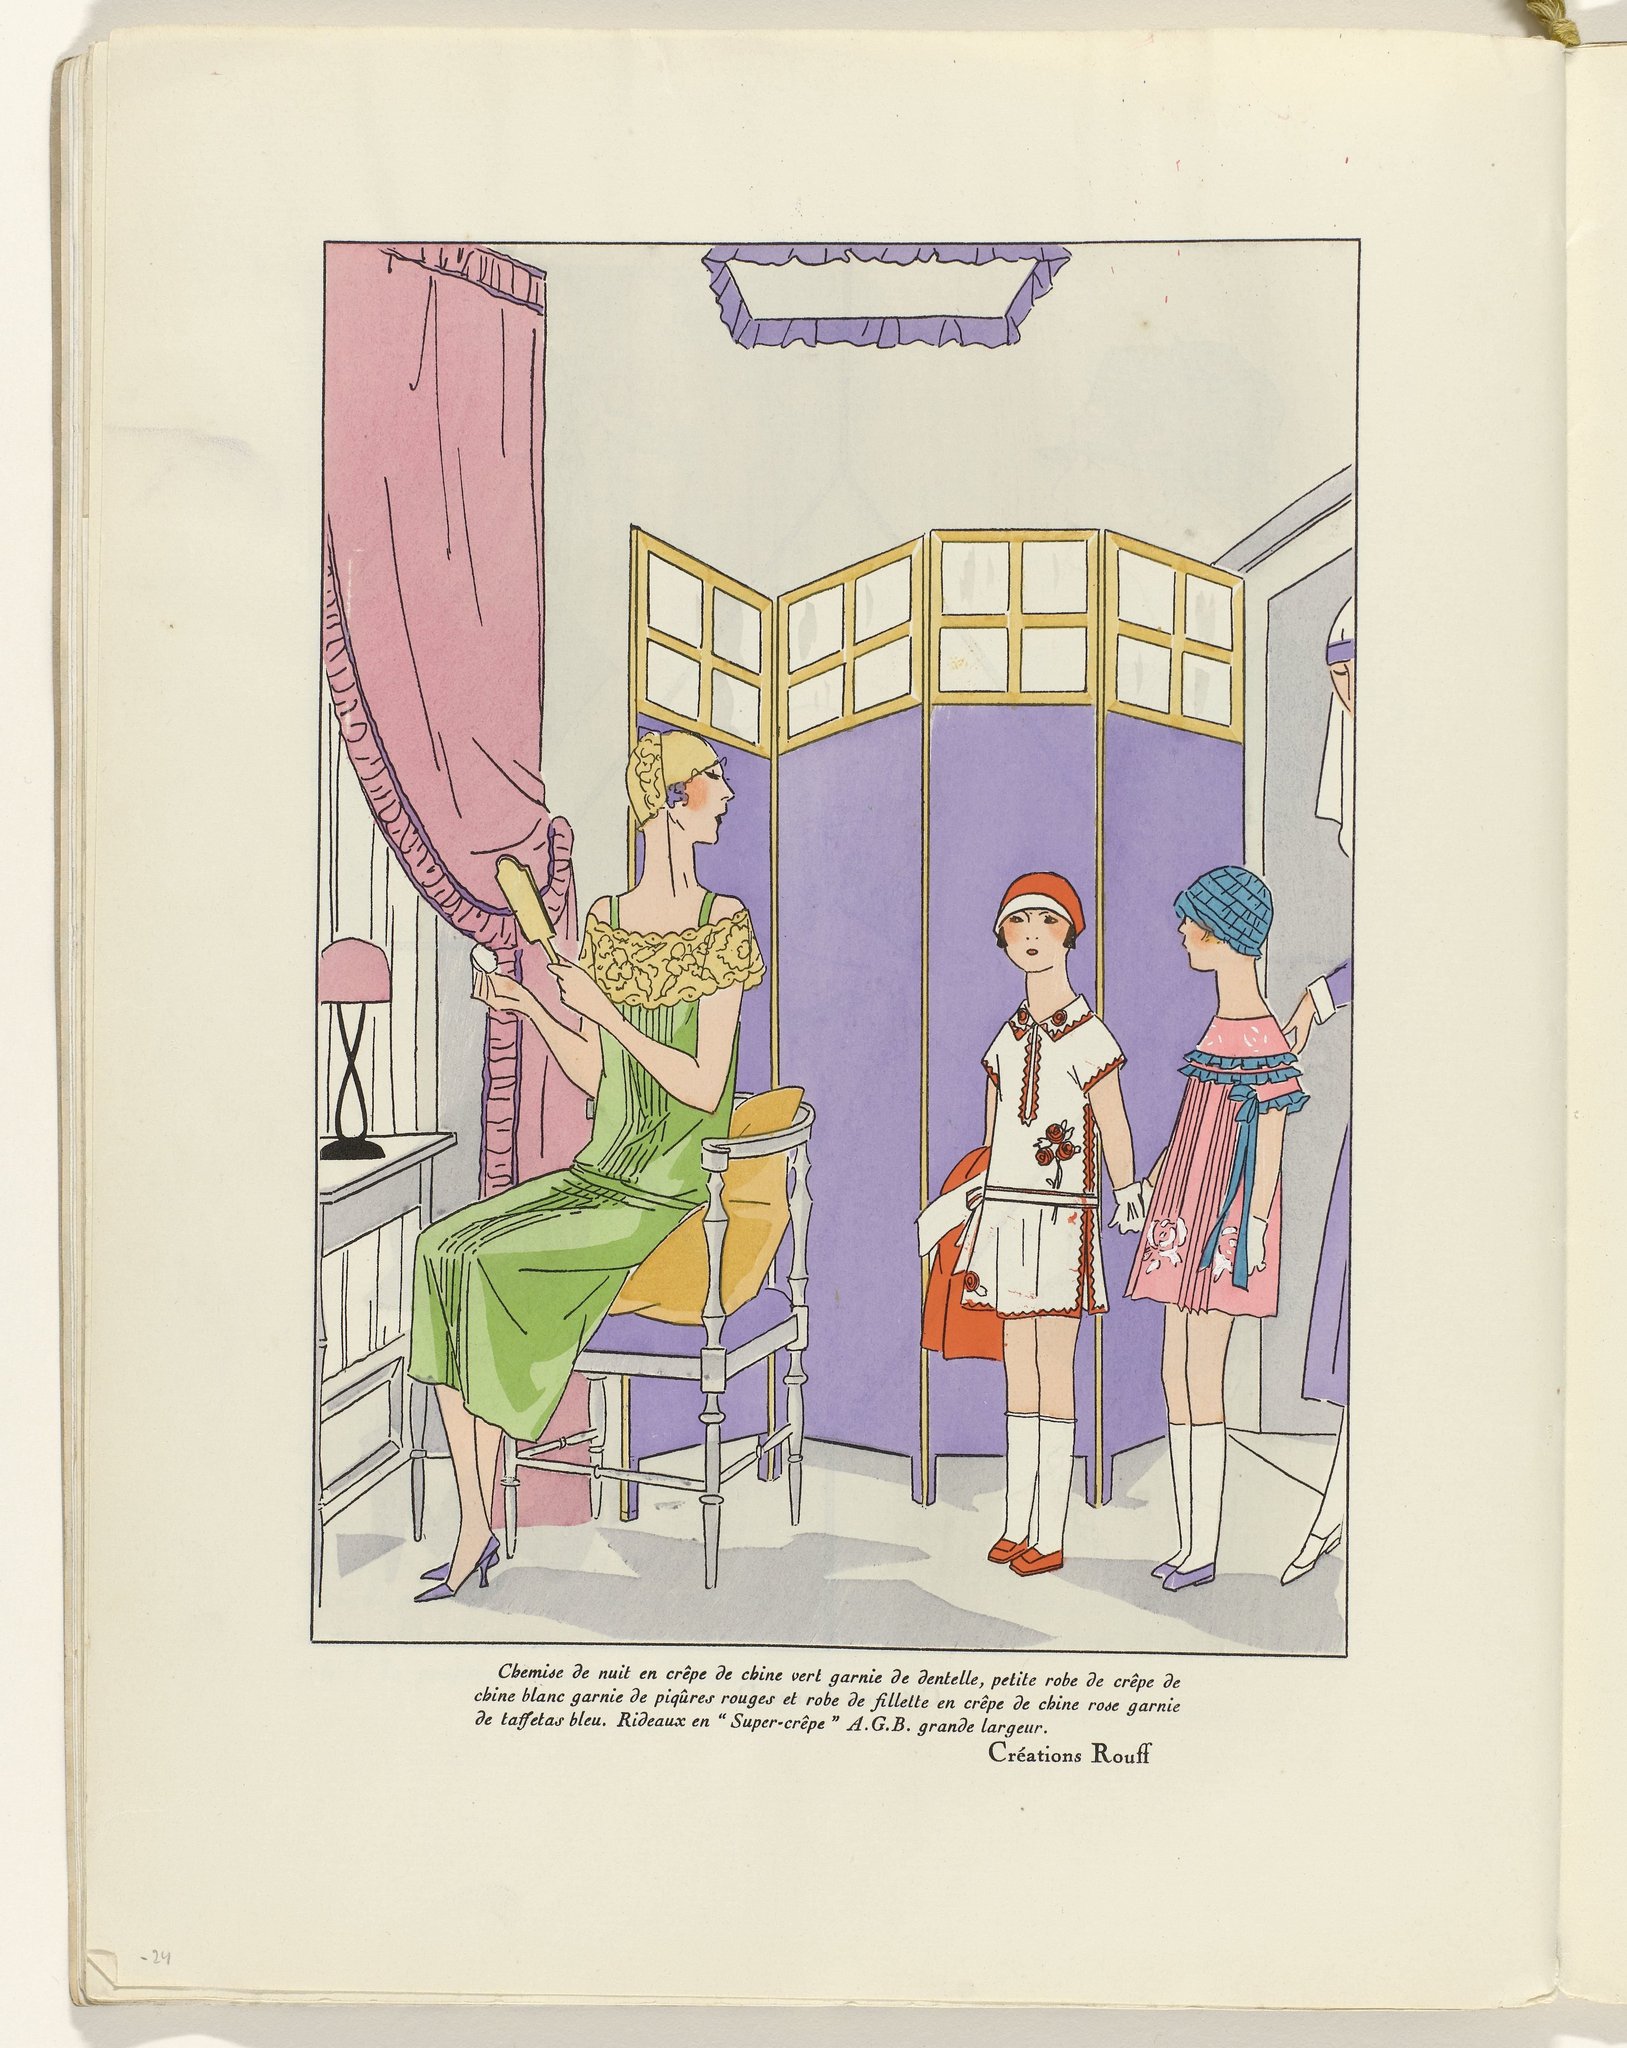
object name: fashion print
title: Art - Goût - Beauté, Feuillets de l' élégance féminine, Février 1926, No. 66, 6e Année, p. 24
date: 1926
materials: paper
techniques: hand coloring, lithograph, pochoir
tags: powder ~ making toilet, lace (+ women's clothes), nightwear: night-gown (+ women's clothes), fashion plates, screen, folding screen, dress, gown (+ girls' clothes)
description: Interieur met vrouw aan toilettafel en twee kinderen en op de achtergrond een kamerscherm. De vrouw draagt een nachtjapon van groene crêpe de chine, versierd met kant. Meisjes in kinderjurken van witte en roze crêpe de chine. Ontwerpen van Maggy Rouff. Pagina uit het modetijdschrift Art-Goût-Beauté (1920-1933).